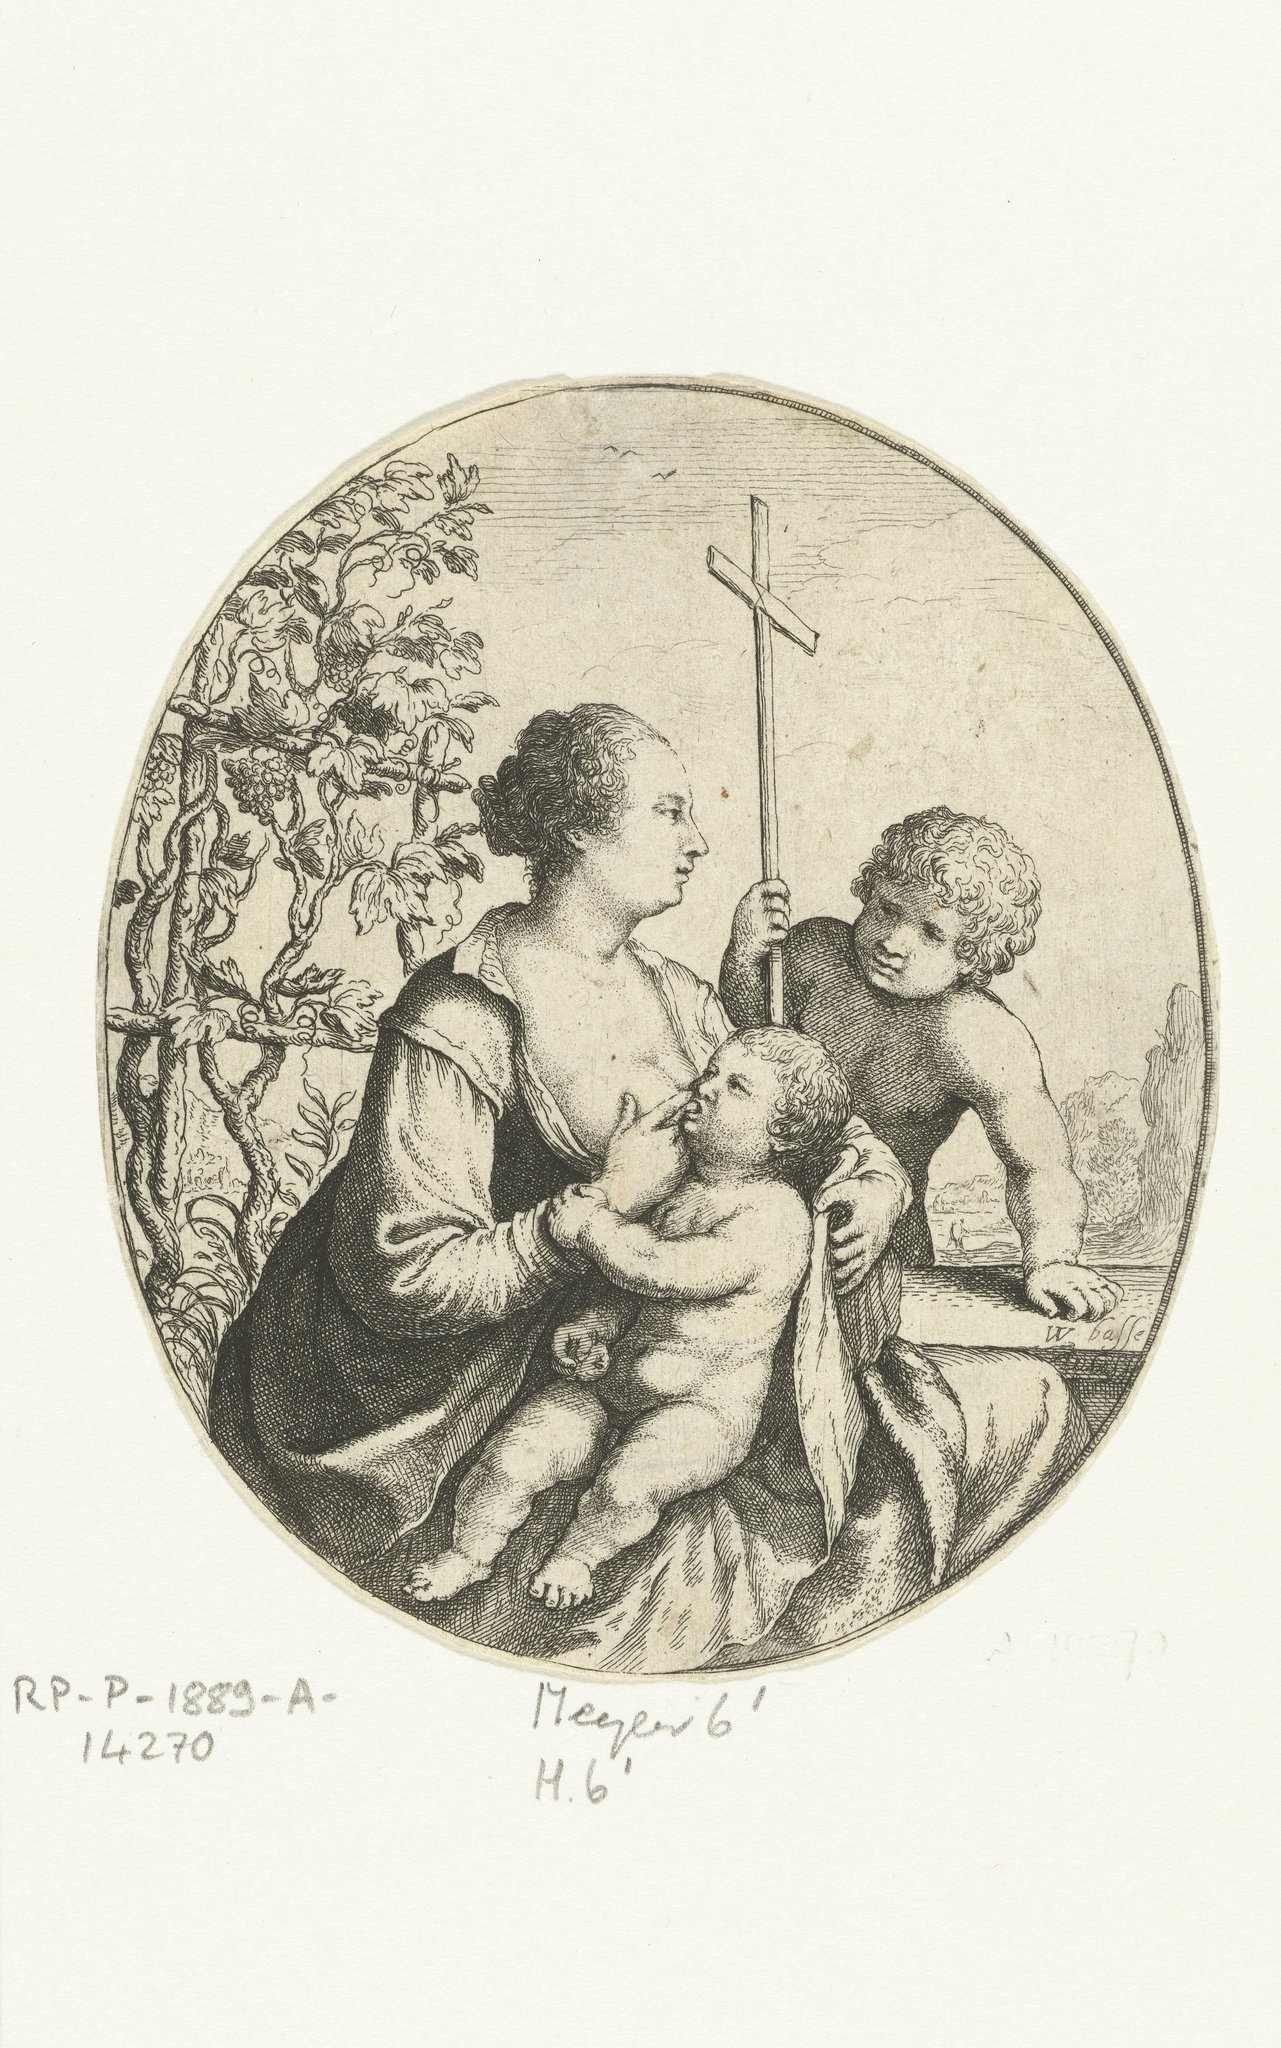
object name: print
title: Maria met Christus en Johannes de Doper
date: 1633-1672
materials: paper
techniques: etching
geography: amsterdam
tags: madonna: mary standing (or half-length), christ-child close to her bosom, mary and the christ-child with john the baptist (as child), john the baptist as child ~ madonna-representations (n.b. secondary notation only)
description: Maria geeft Christus de borst. Johannes de Doper met het kruis staat achter hen.